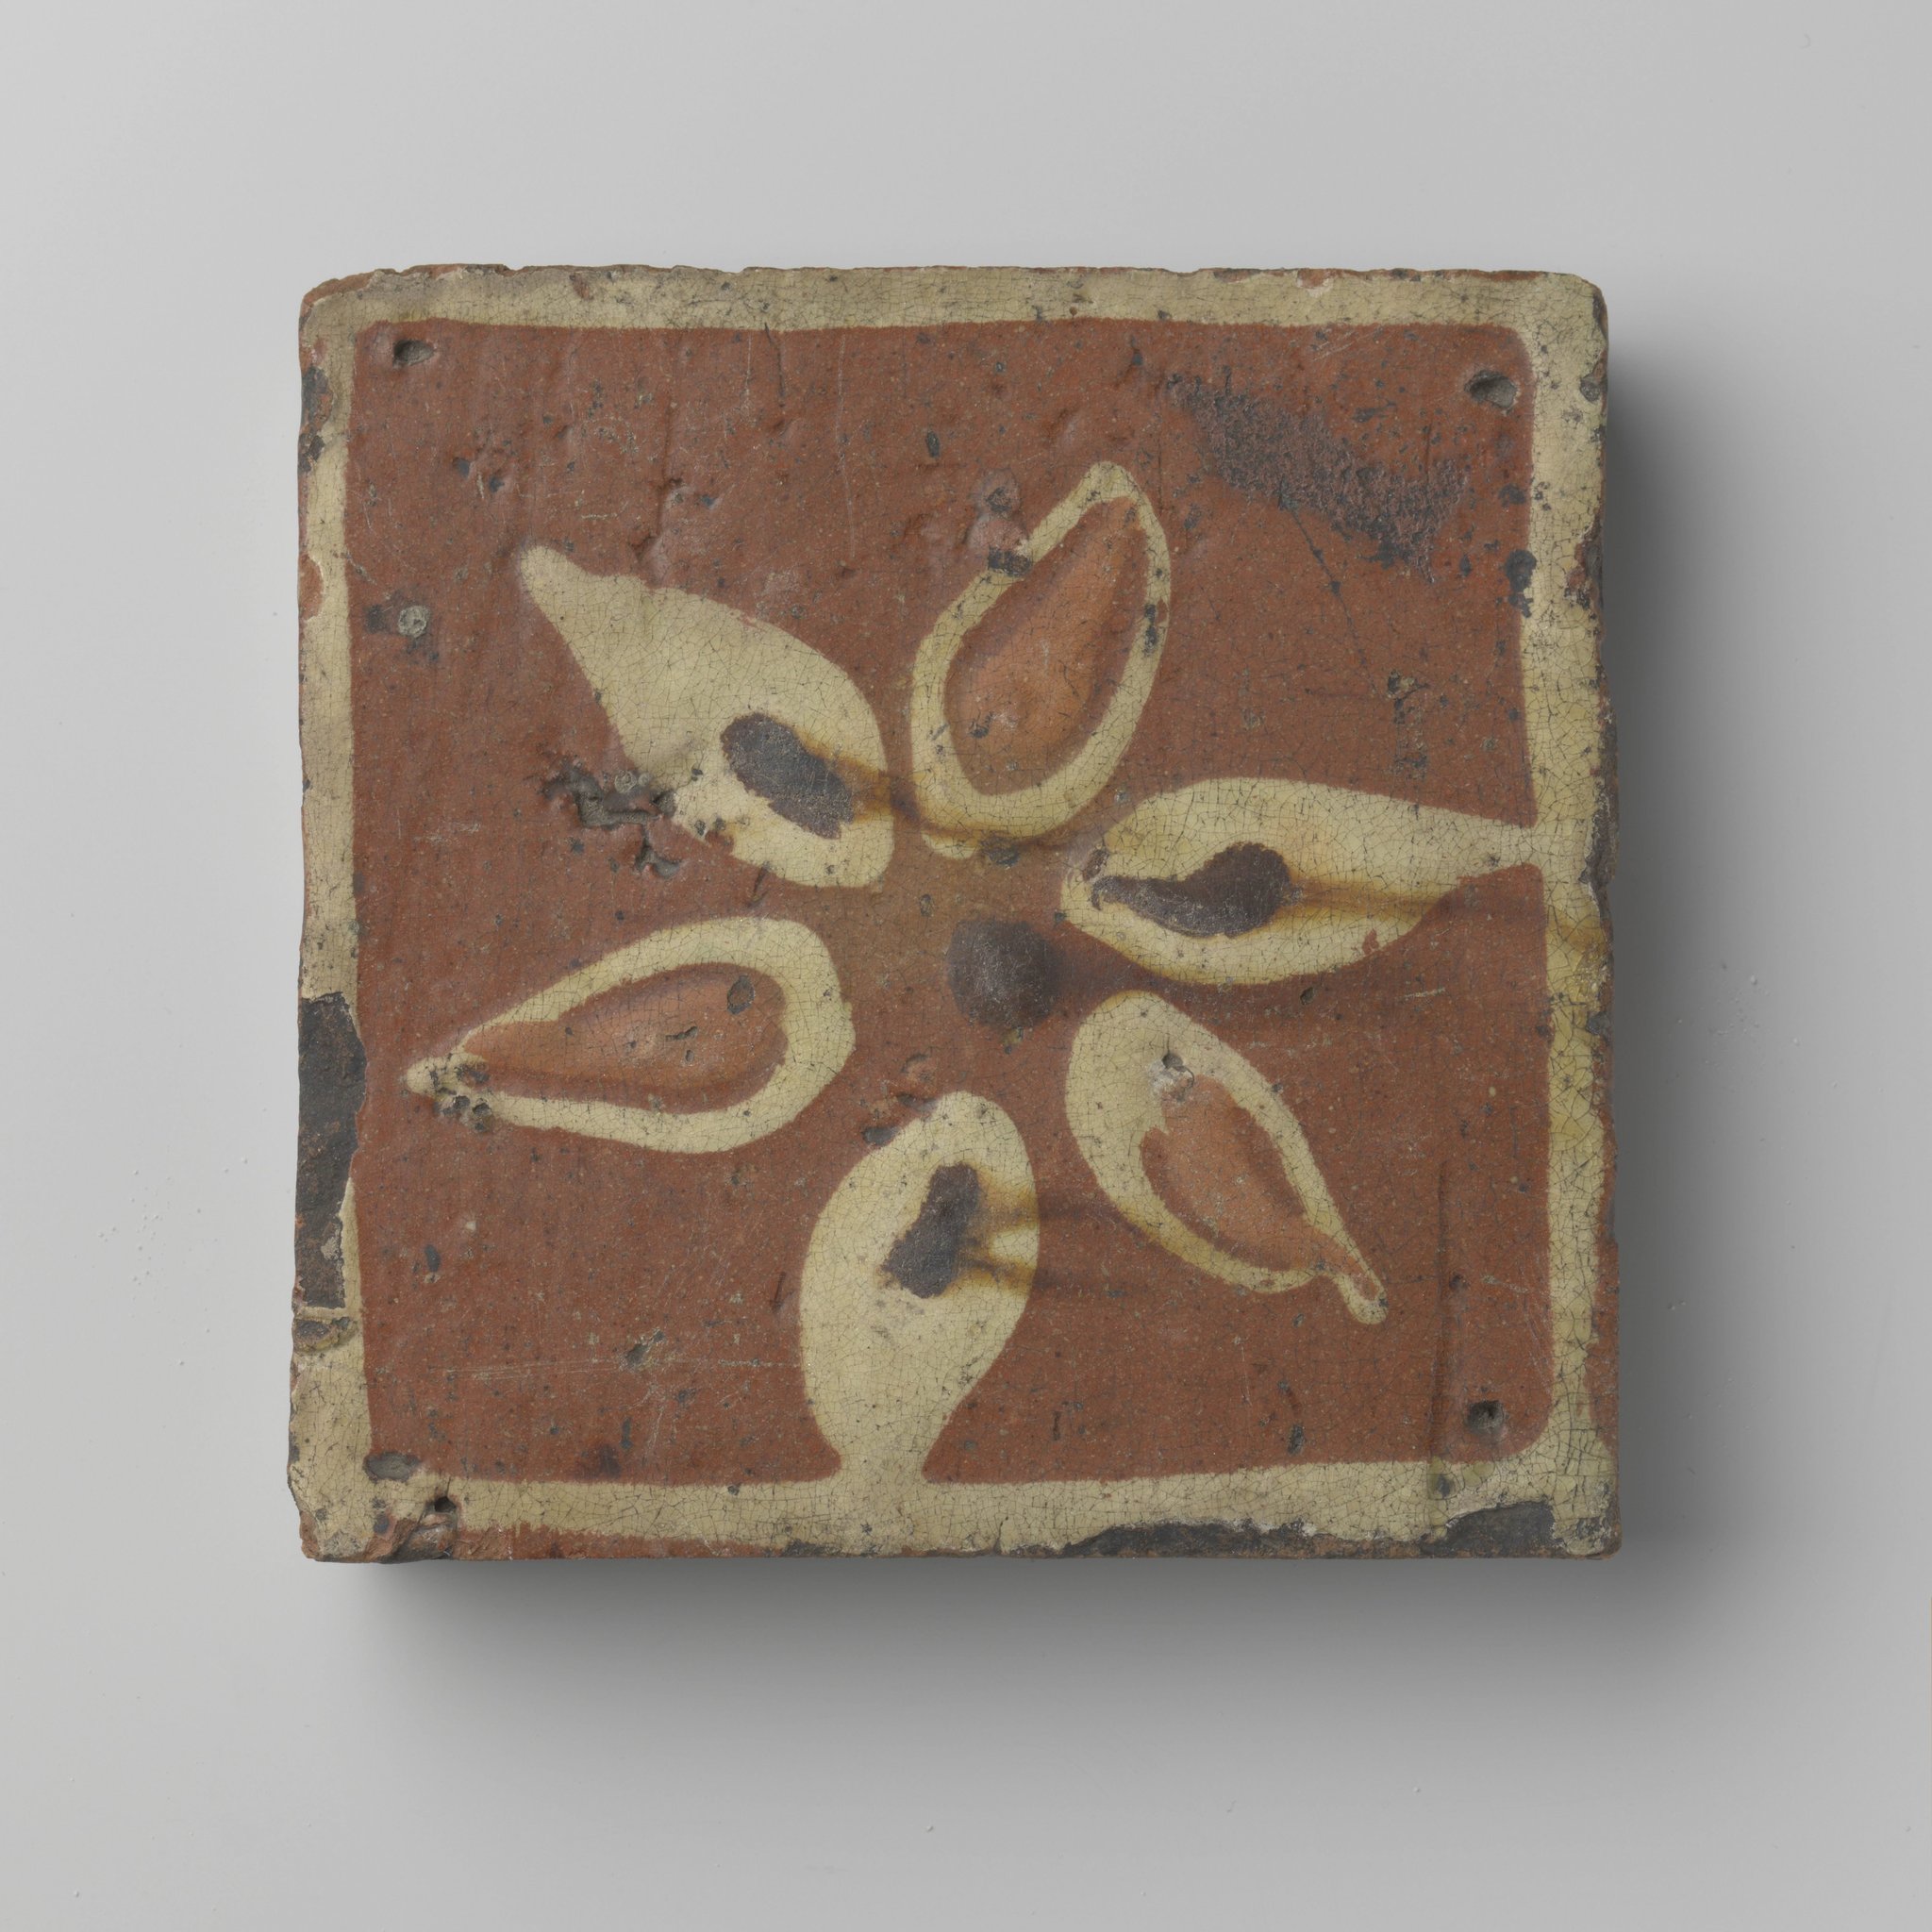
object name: tile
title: Tegel, vierkant, van aardewerk aan de voorzijde gedekt met loodglazuur en versierd met een rand van witte slib, daarbinnen een ster van witte slib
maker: Anonymous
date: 1700-1800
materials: earthenware, glaze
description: Tegel, vierkant, van aardewerk aan de voorzijde gedekt met loodglazuur en versierd met een rand van witte slib, daarbinnen een ster van witte slib waarop rode en paarsbruine vlekken zijn aangebracht. Limburgs werk.